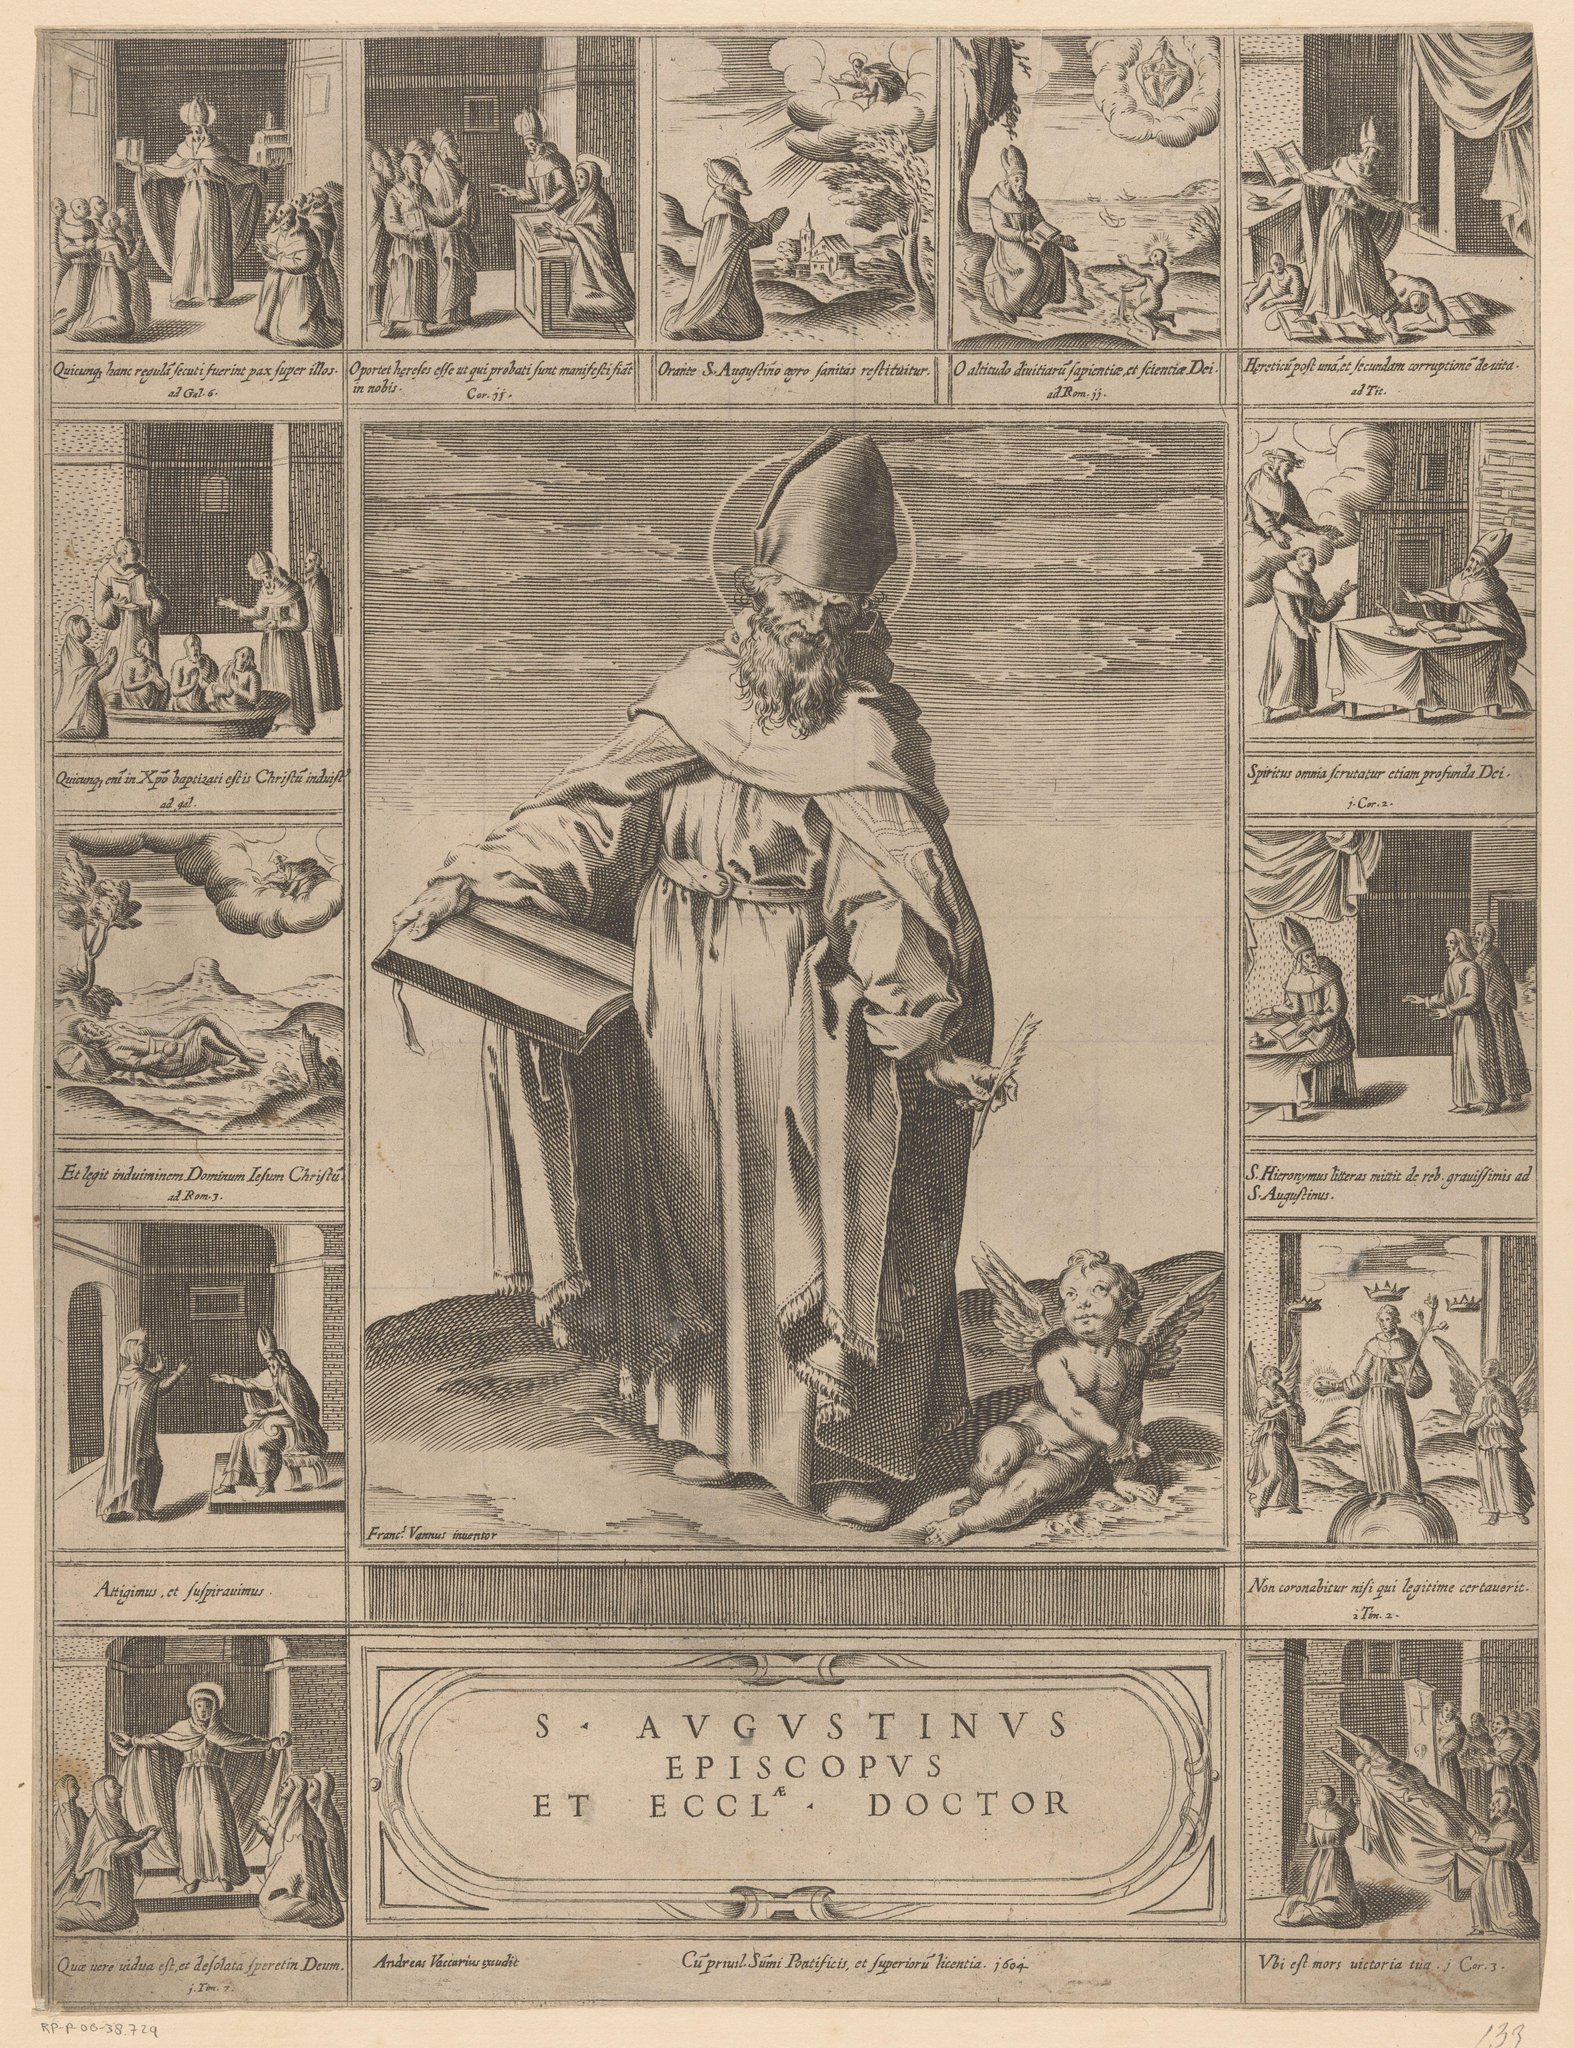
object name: print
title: Leven van de heilige Augustinus van Hippo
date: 1604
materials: paper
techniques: engraving, etching, intaglio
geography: italy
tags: augustine, bishop of hippo; possible attributes: arrows piercing his breast, book, child with spoon, flaming heart, heart (pierced with arrows), pen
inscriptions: collector's mark: Lugt 240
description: Deze prent maakt deel uit van een door Andrea Vaccari uitgegeven serie, bestaande uit ten minste tien prenten met voorstellingen van heiligen, omringd door kleinere voorstellingen met scènes uit het leven van desbetreffende heilige.